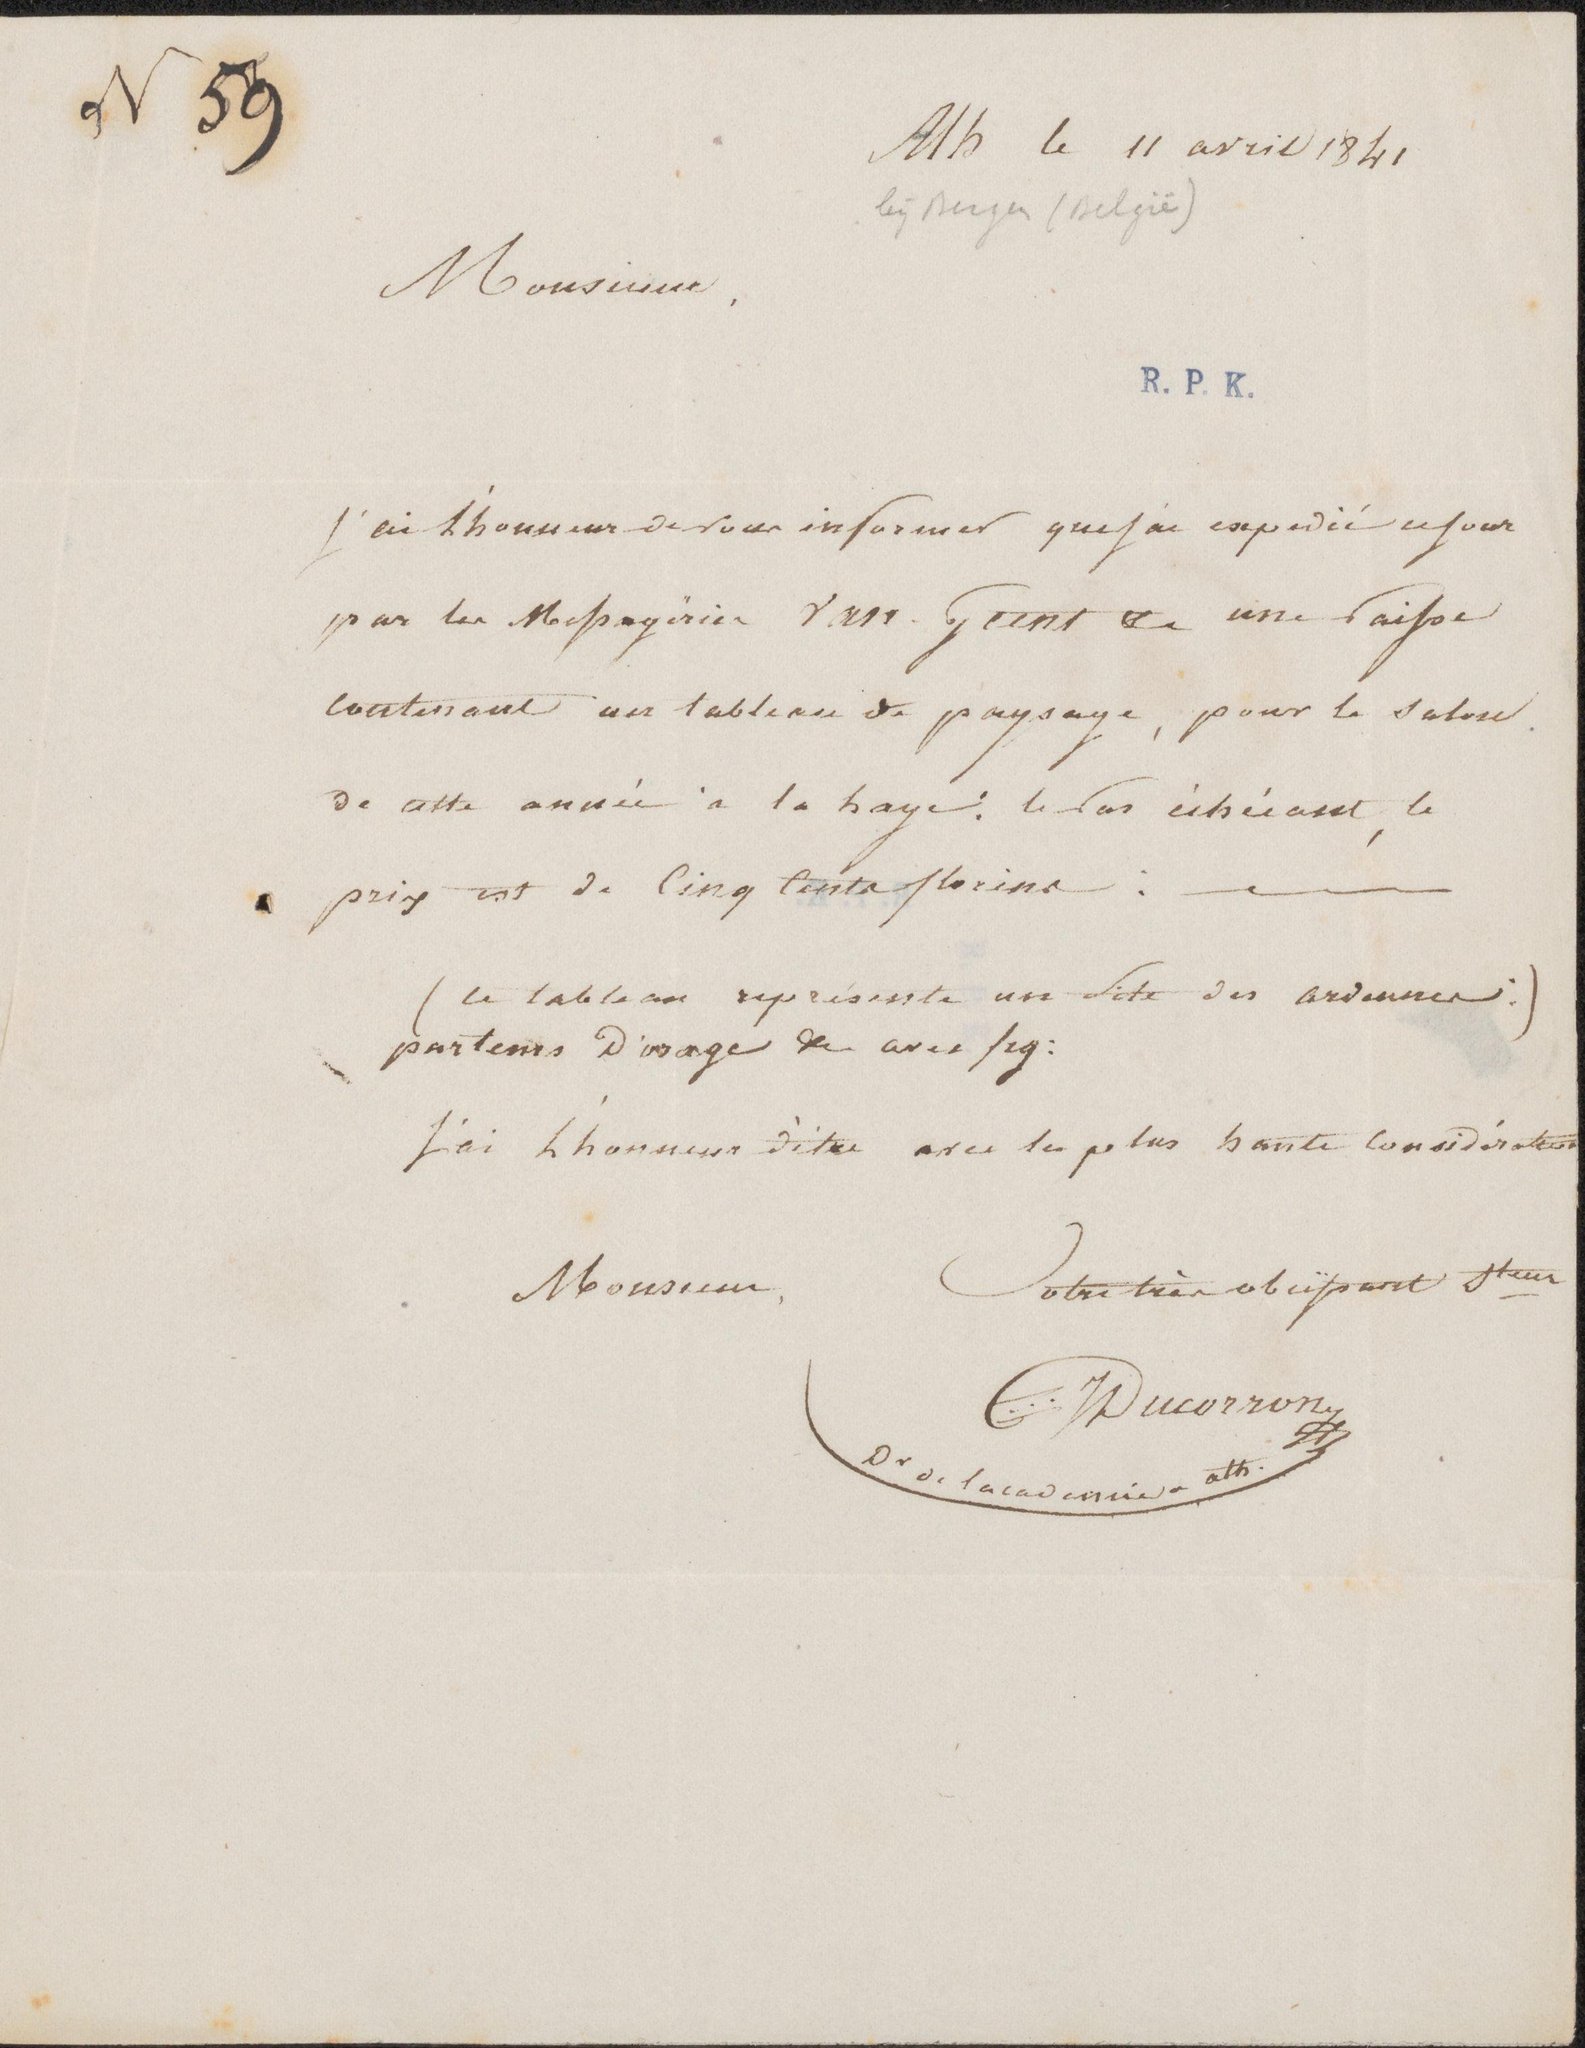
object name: letter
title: Brief aan G.M.C. Hooft, secretaris van de commissie van de Tentoonstelling van Levende Meesters in Den Haag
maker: julien joseph ducorron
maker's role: painter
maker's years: 1770-1848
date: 1841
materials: ink, paper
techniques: pen, writing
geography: ath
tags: painting (including book-illumination, miniature-painting), exhibition ~ art, money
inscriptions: collector's mark: Lugt 2233